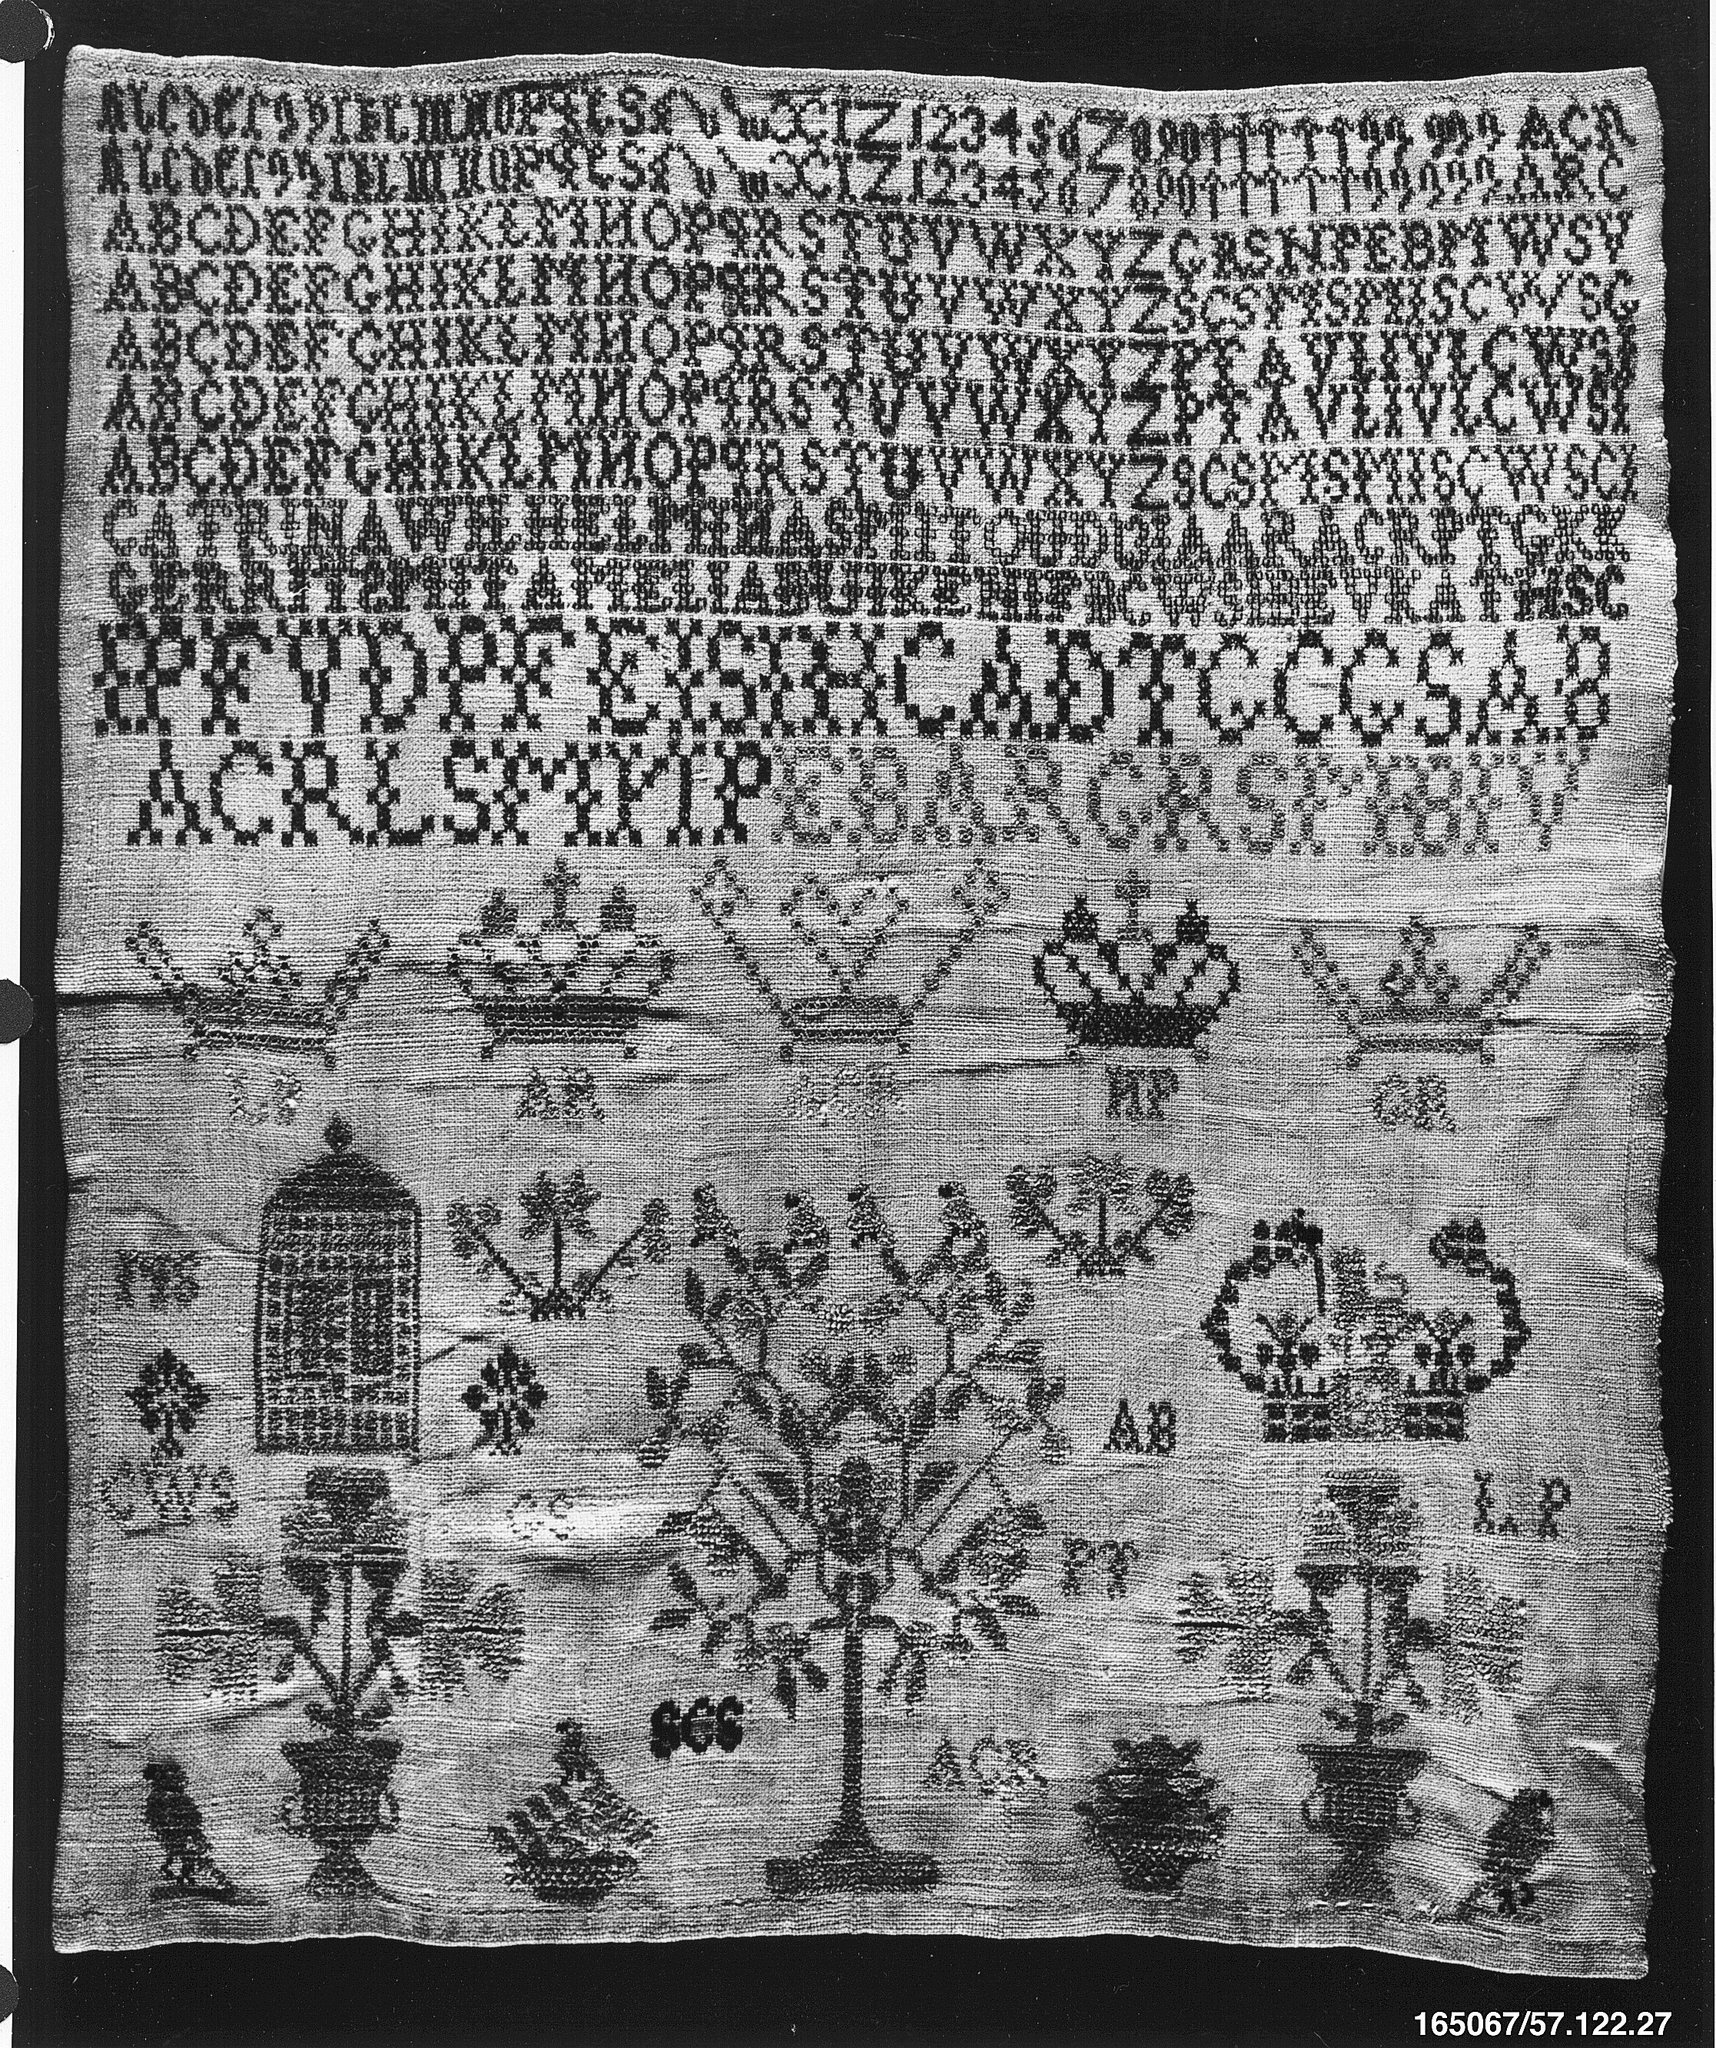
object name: sampler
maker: catharina (catrina) wilhelmina smit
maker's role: artist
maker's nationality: dutch, born 17th may 1818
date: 1832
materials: linen, silk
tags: birds,flowers